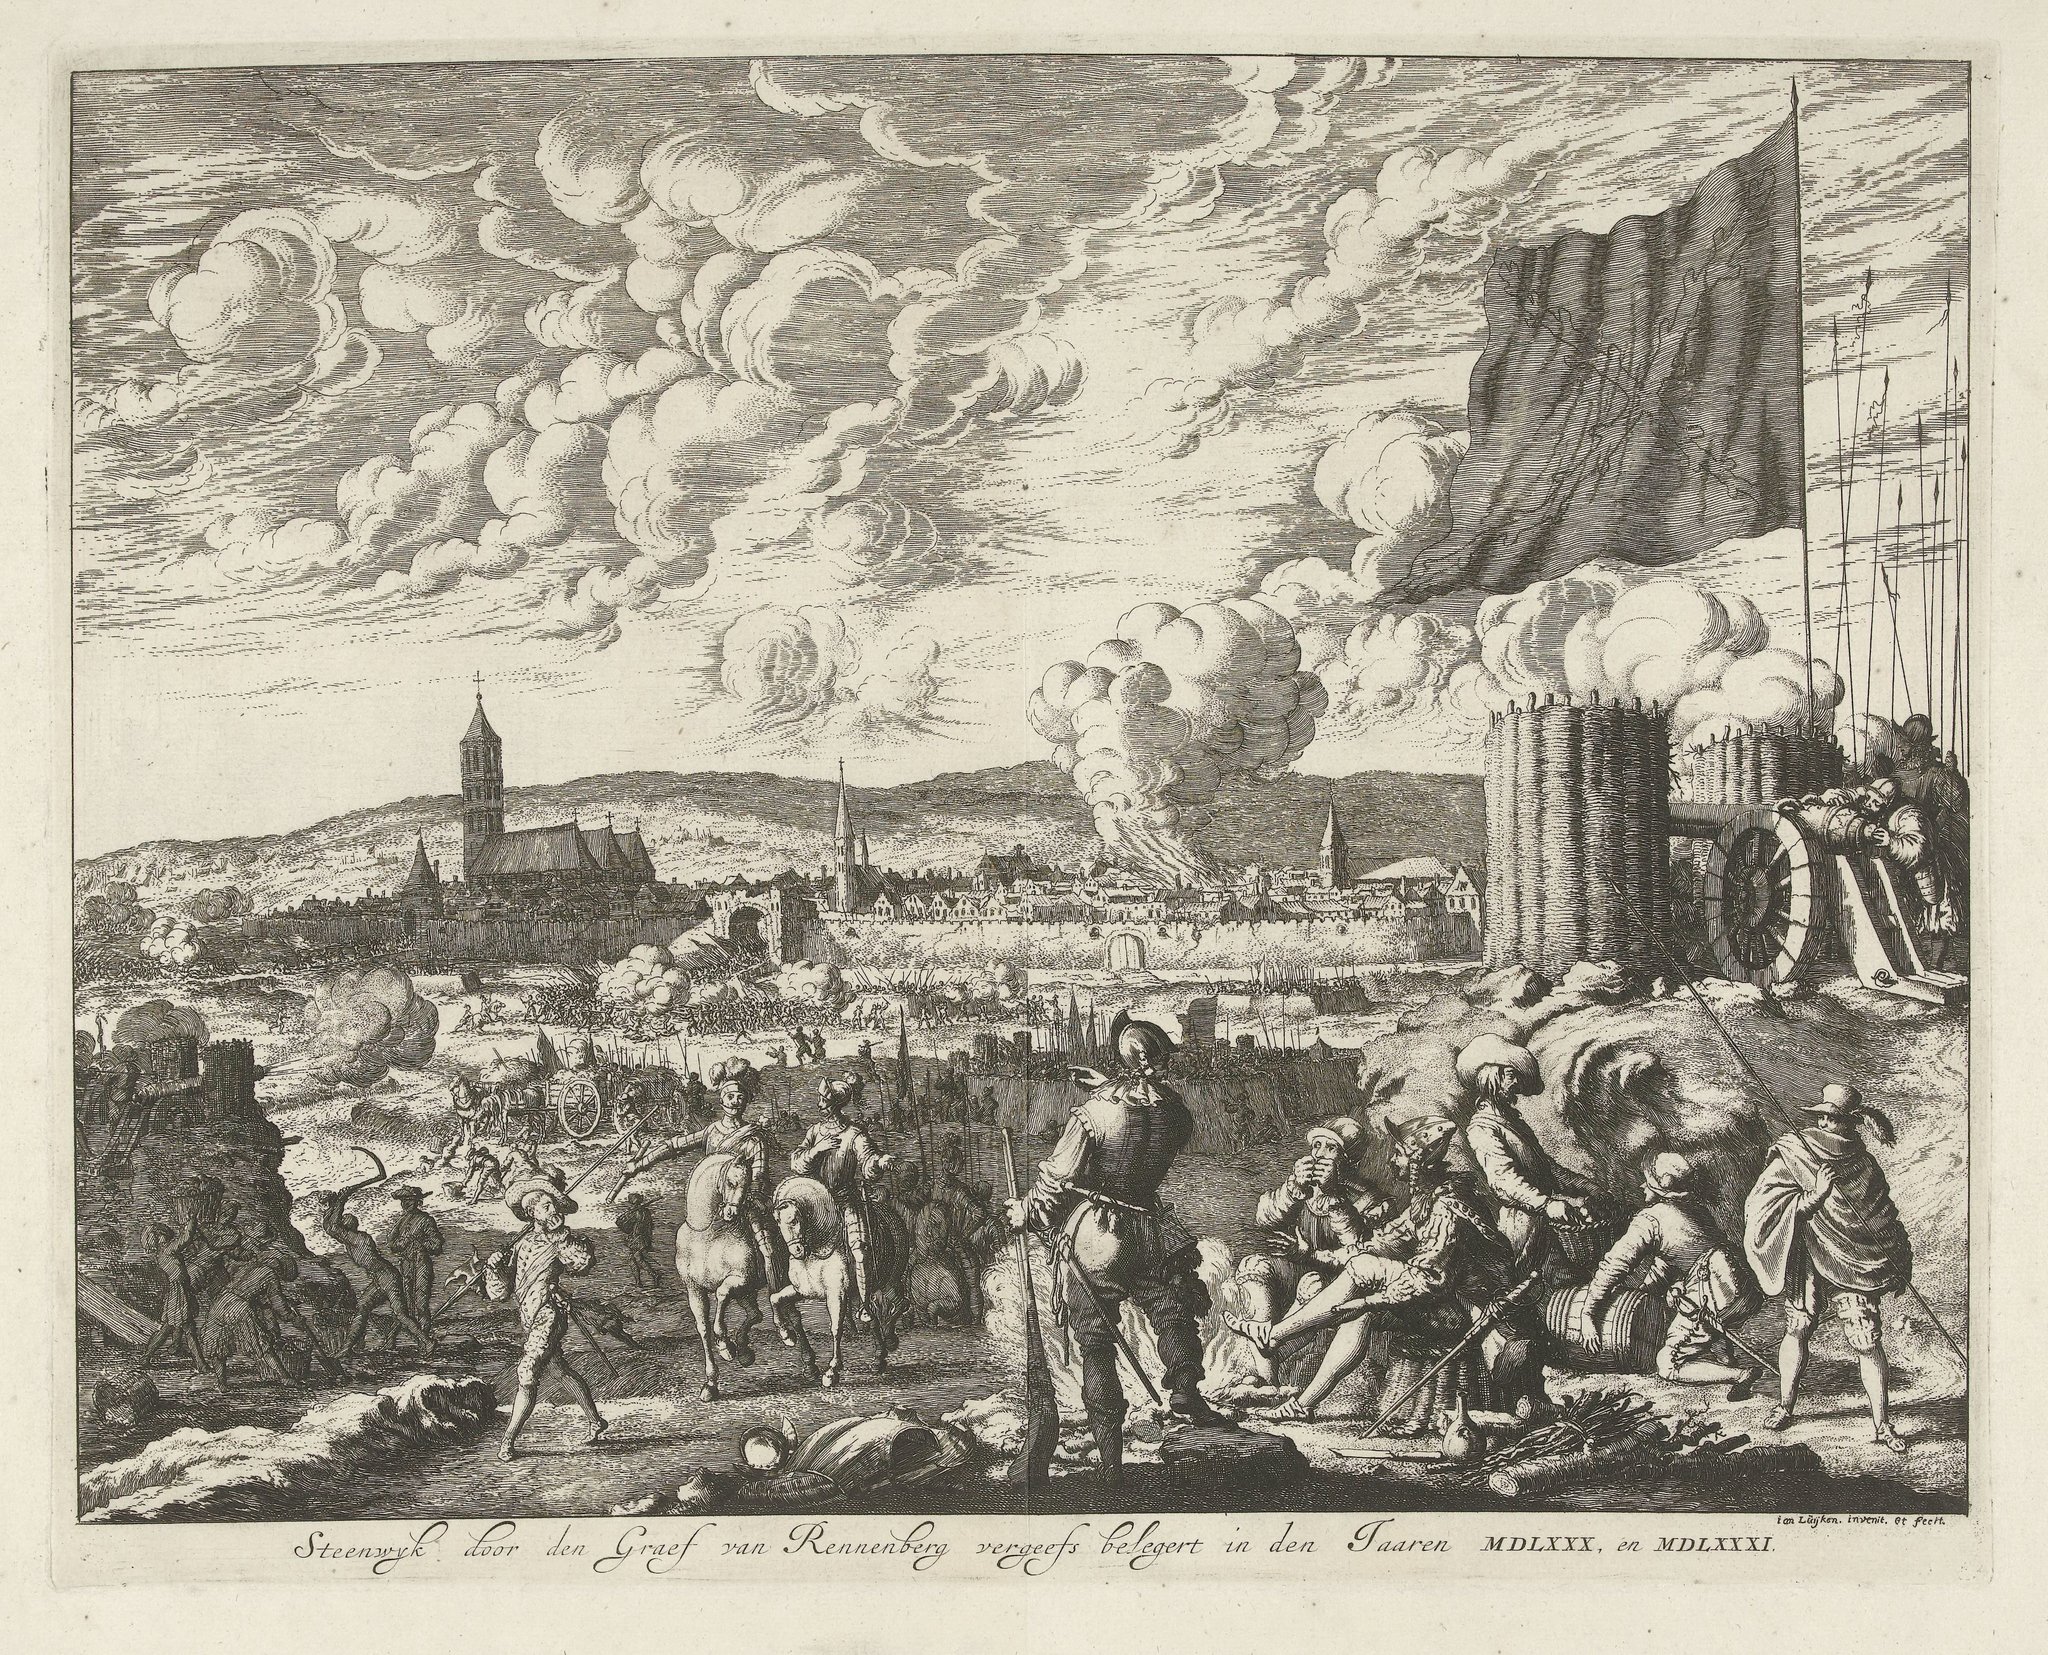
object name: print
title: Steenwyk door den Graef van Rennenberg vergeefs belegert in den Jaaren MDLXXX en MDLXXXI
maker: jan luyken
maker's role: draughtsman, print maker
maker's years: 1649-1712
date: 1678-1680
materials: paper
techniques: etching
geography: northern netherlands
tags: groningen (province), politician, capture of city (after the siege)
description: Gebruikt als illustratie in: P. Bor Christiaensz., Oorsprongk, begin, en vervolgh der Nederlandsche Oorlogen, Amsterdam 1679-1684, 4 delen, dl. II (1680), p. 239.